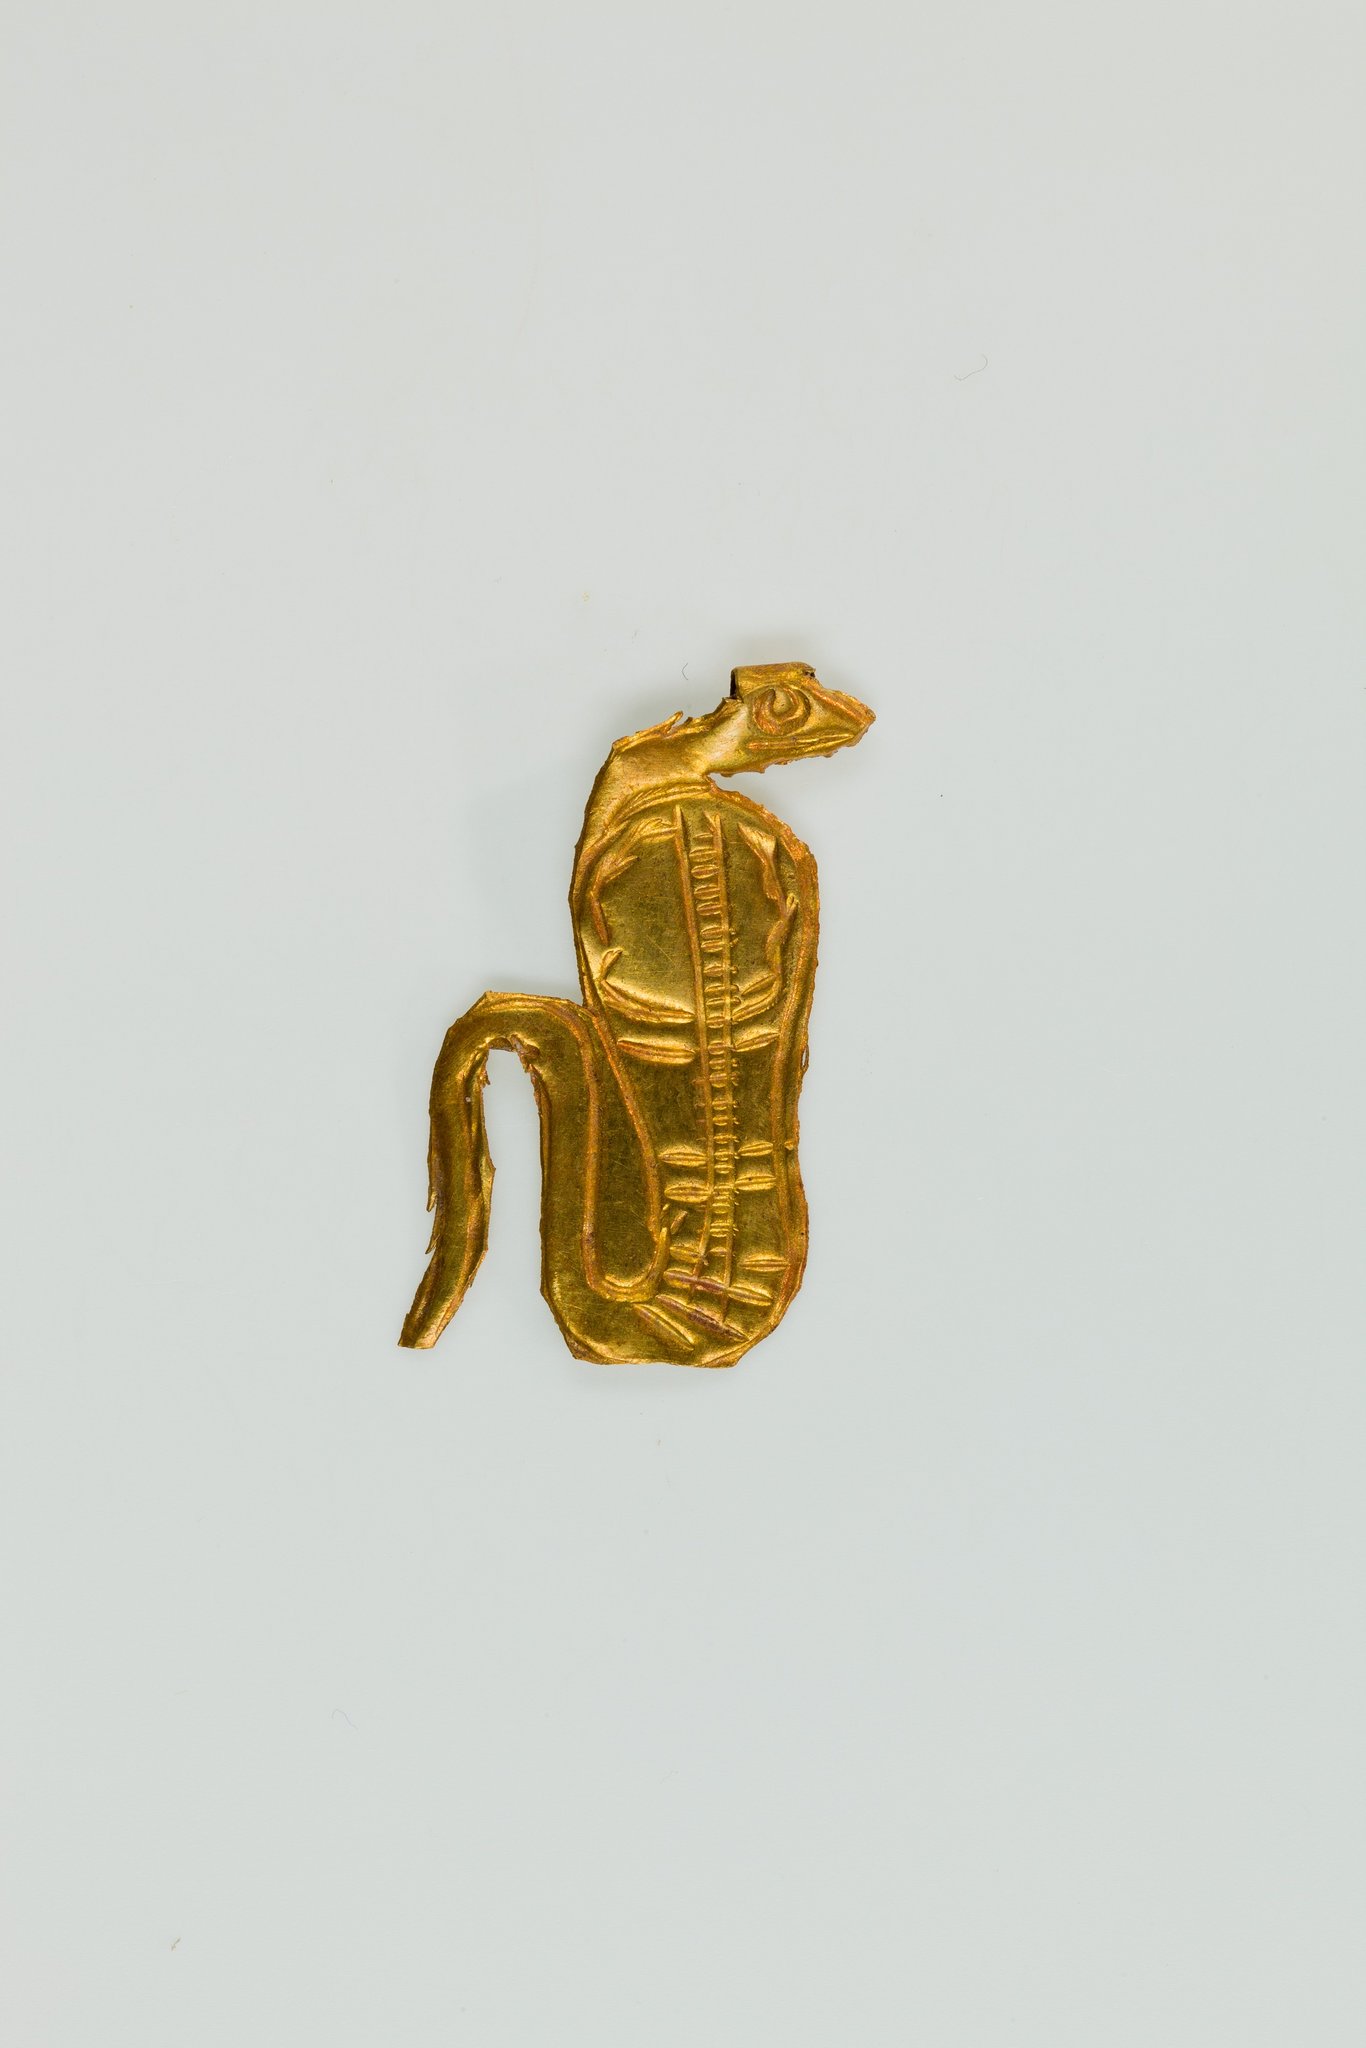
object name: amulet, uraeus, djedmutesankh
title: Uraeus Amulet of Djedmutesankh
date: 1000-945 BCE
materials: gold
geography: egypt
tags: serpents